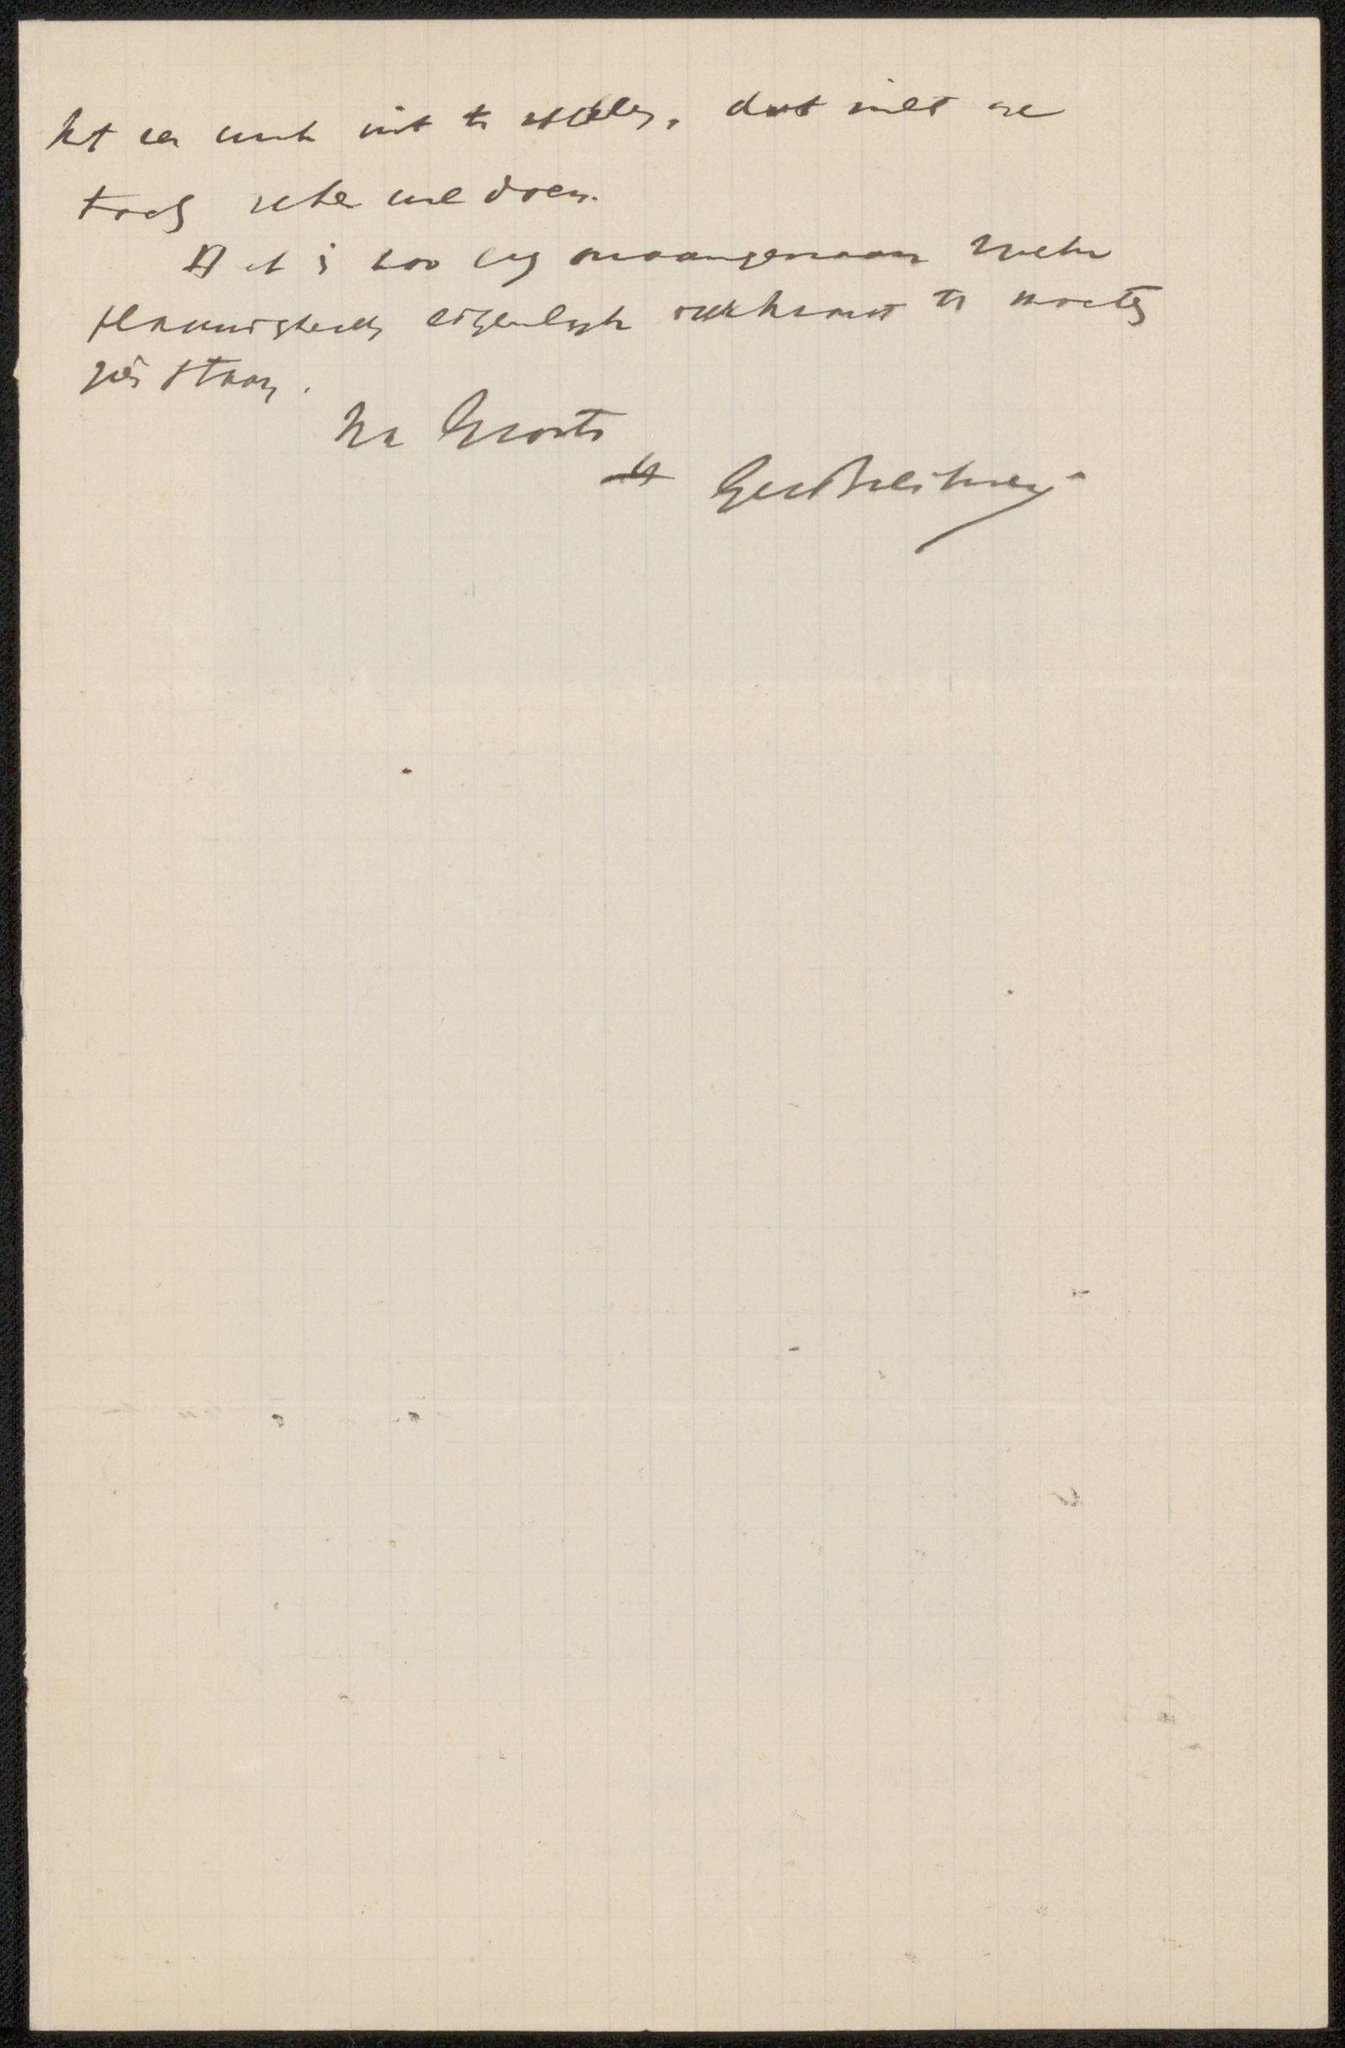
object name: letter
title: Brief aan Jan Veth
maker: george hendrik breitner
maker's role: draughtsman, painter, print maker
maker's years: 1857-1923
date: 1901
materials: ink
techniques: pen, writing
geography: amsterdam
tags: dordrecht, jan veth, rural housing, e.g. country-house, villa, cottage, building-site, the hague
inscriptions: collector's mark: ‘RPK’